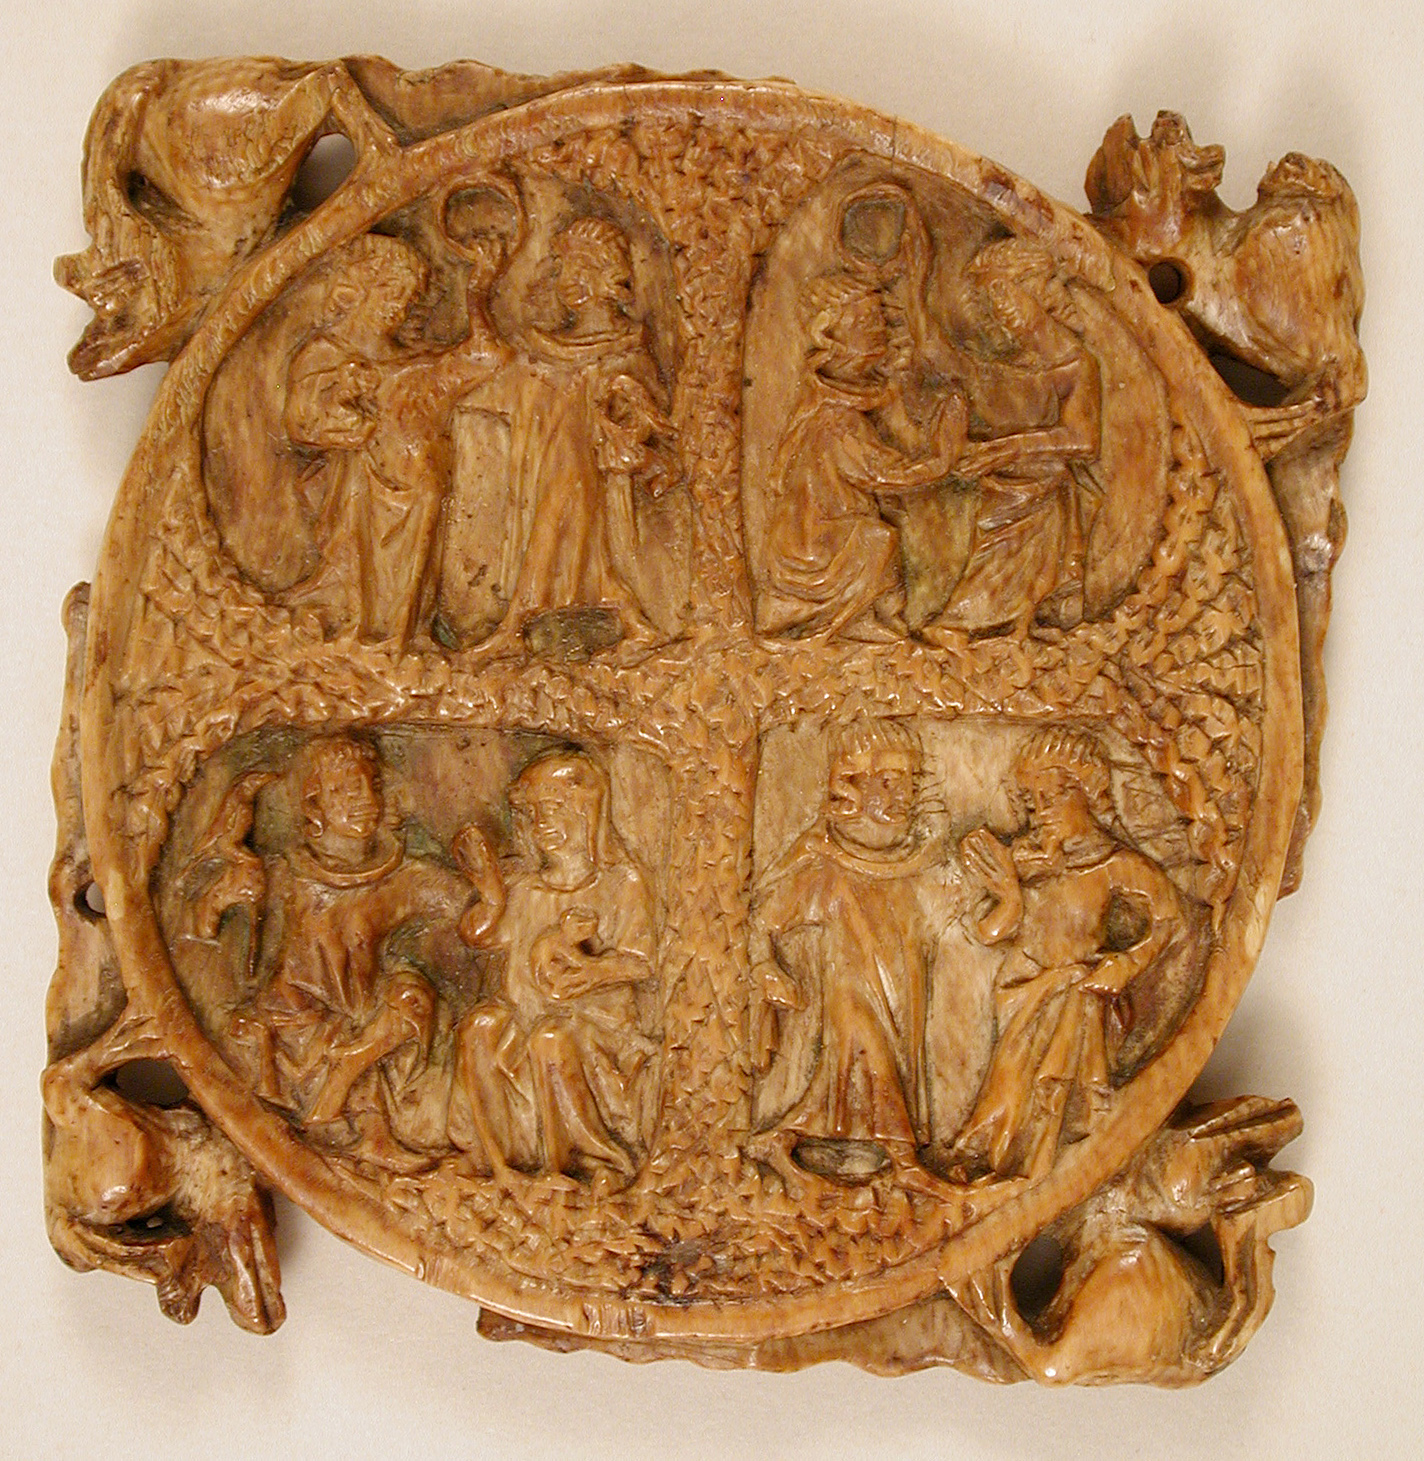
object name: mirror case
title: Mirror Case with Lovers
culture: french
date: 1326-1350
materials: ivory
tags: men,lovers,women